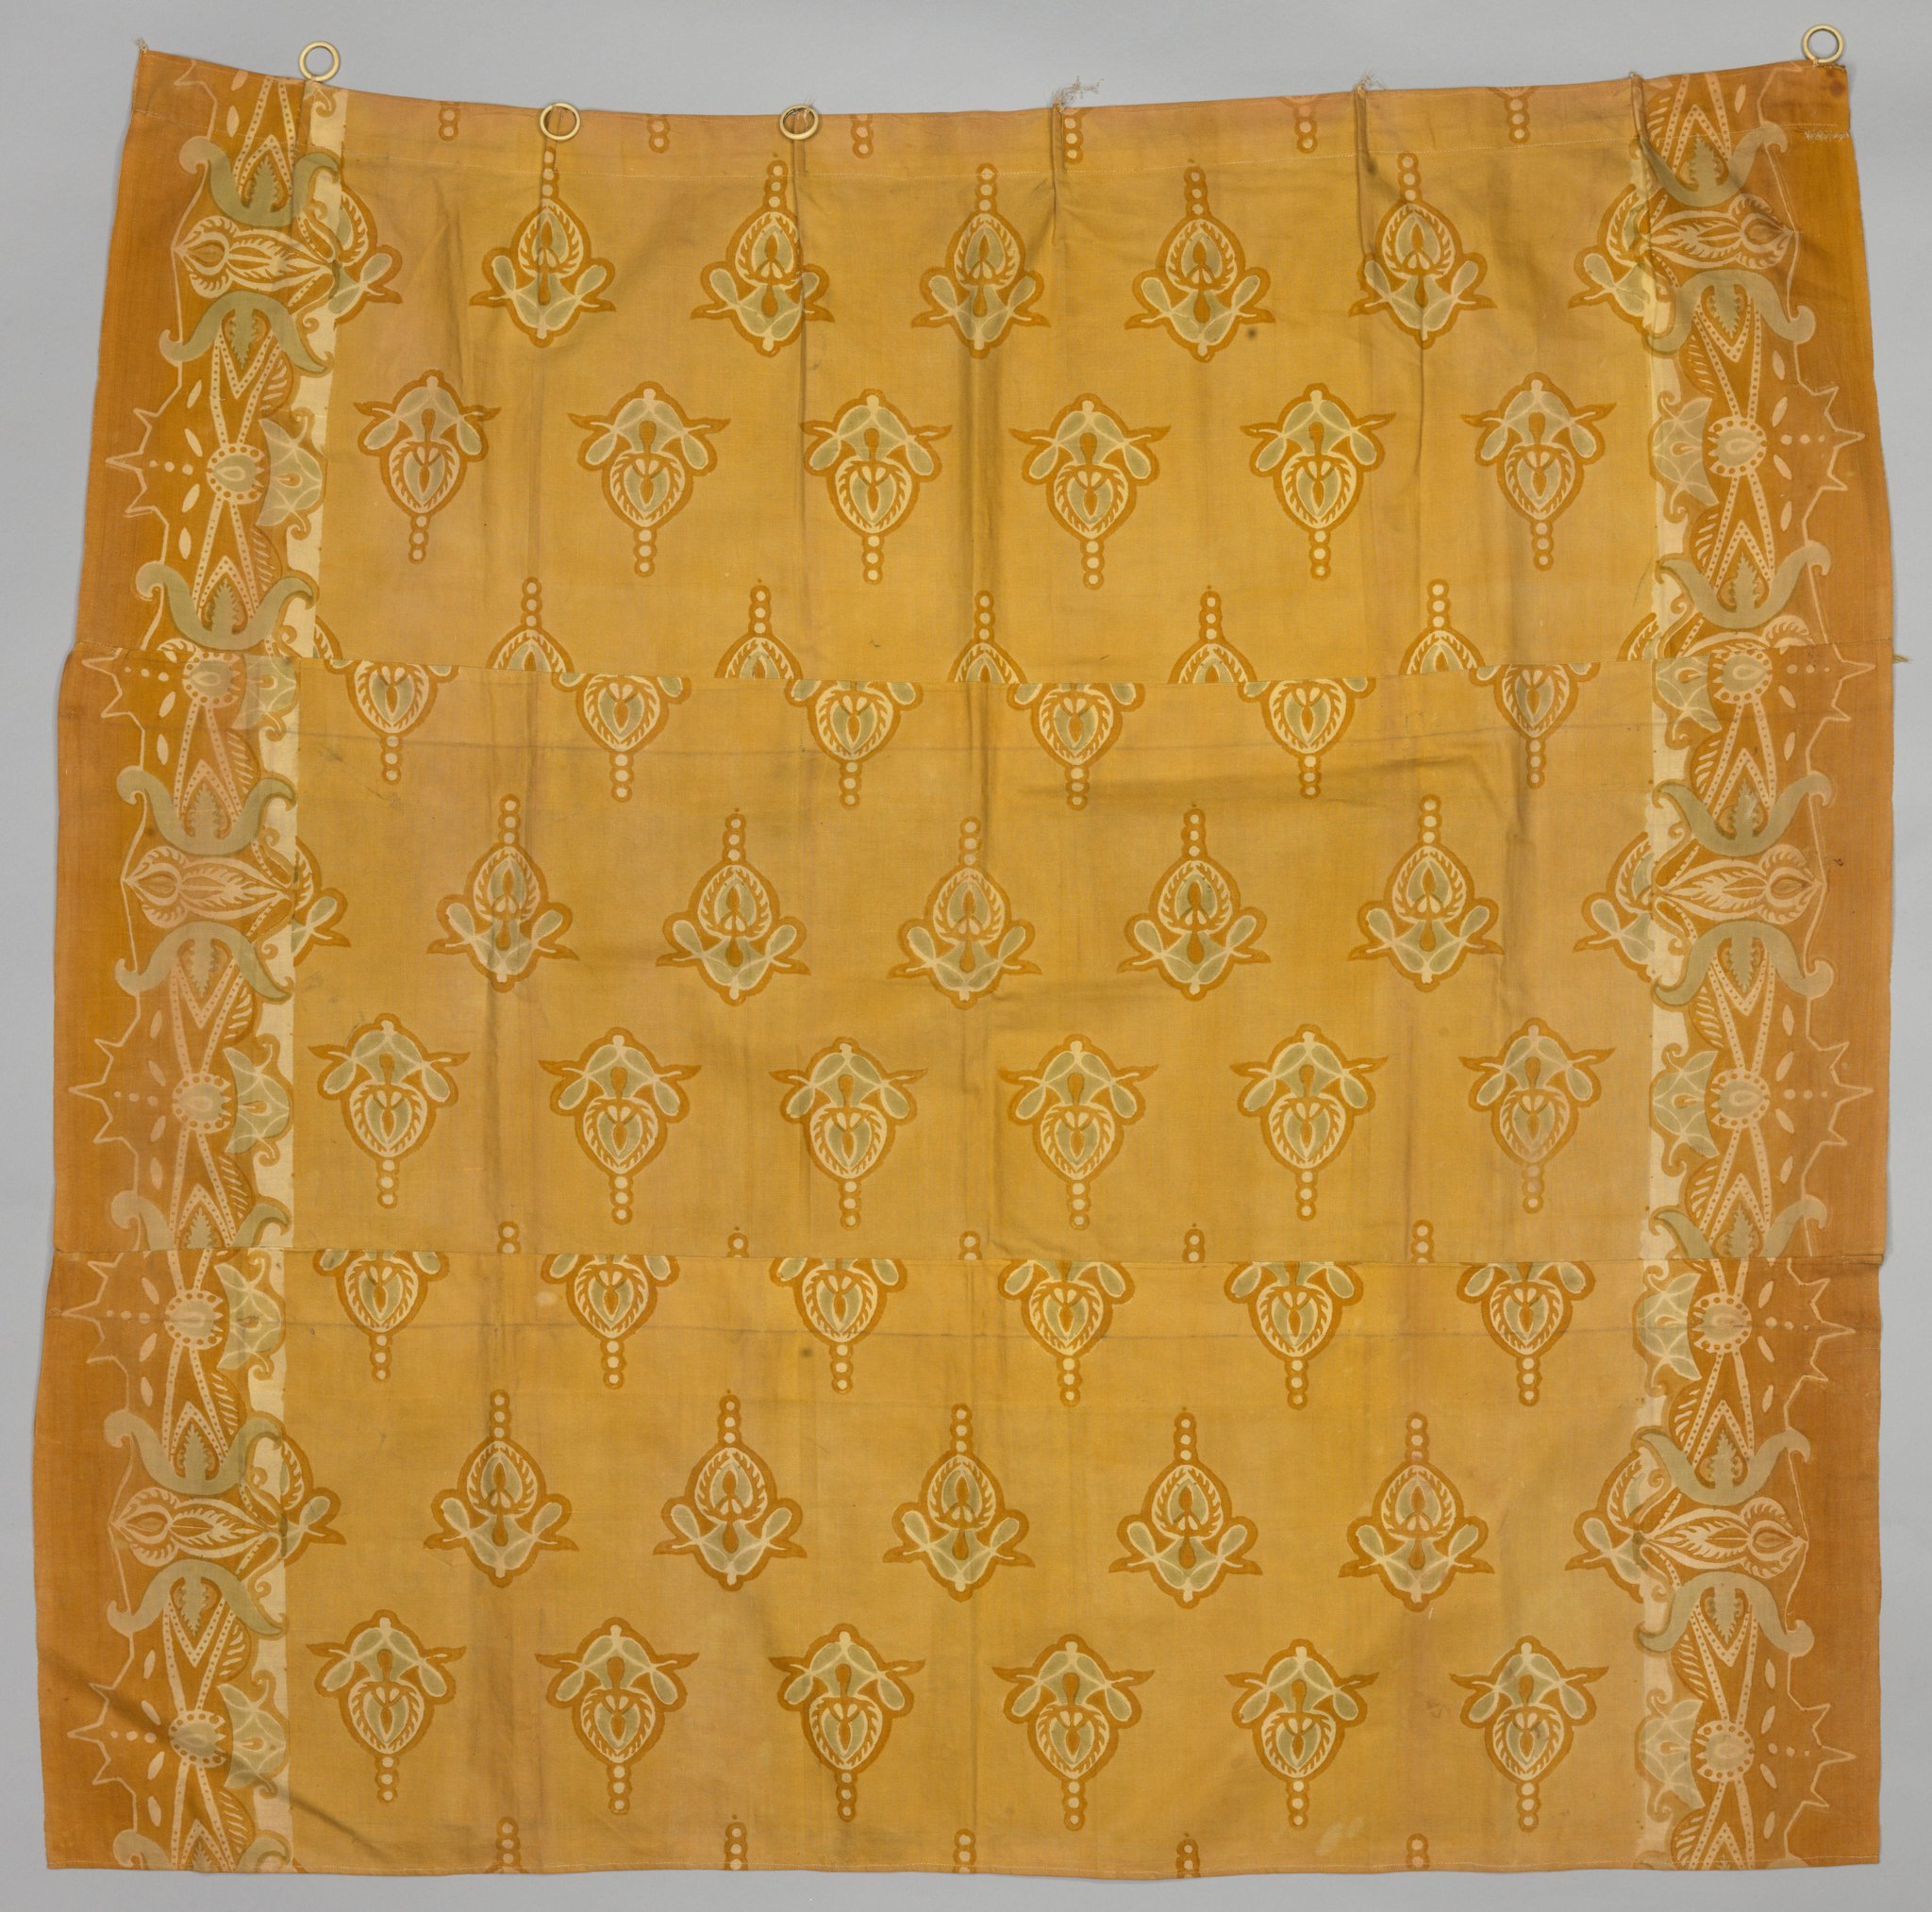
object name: curtain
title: Gordijn van bedrukte cretonne met geometrische decor en pauwen in naturel, okergeel en groen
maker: michiel duco crop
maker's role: designer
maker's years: 1862-1901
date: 1899-1900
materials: cotton, ivory, paint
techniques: printing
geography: netherlands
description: Gordijn, bestaande uit drie aan elkaar genaaide stukken bedrukte cretonne met geometrische decor in naturel, okergeel en lichtgroen. Voorzien van ivoren(?) ringen.